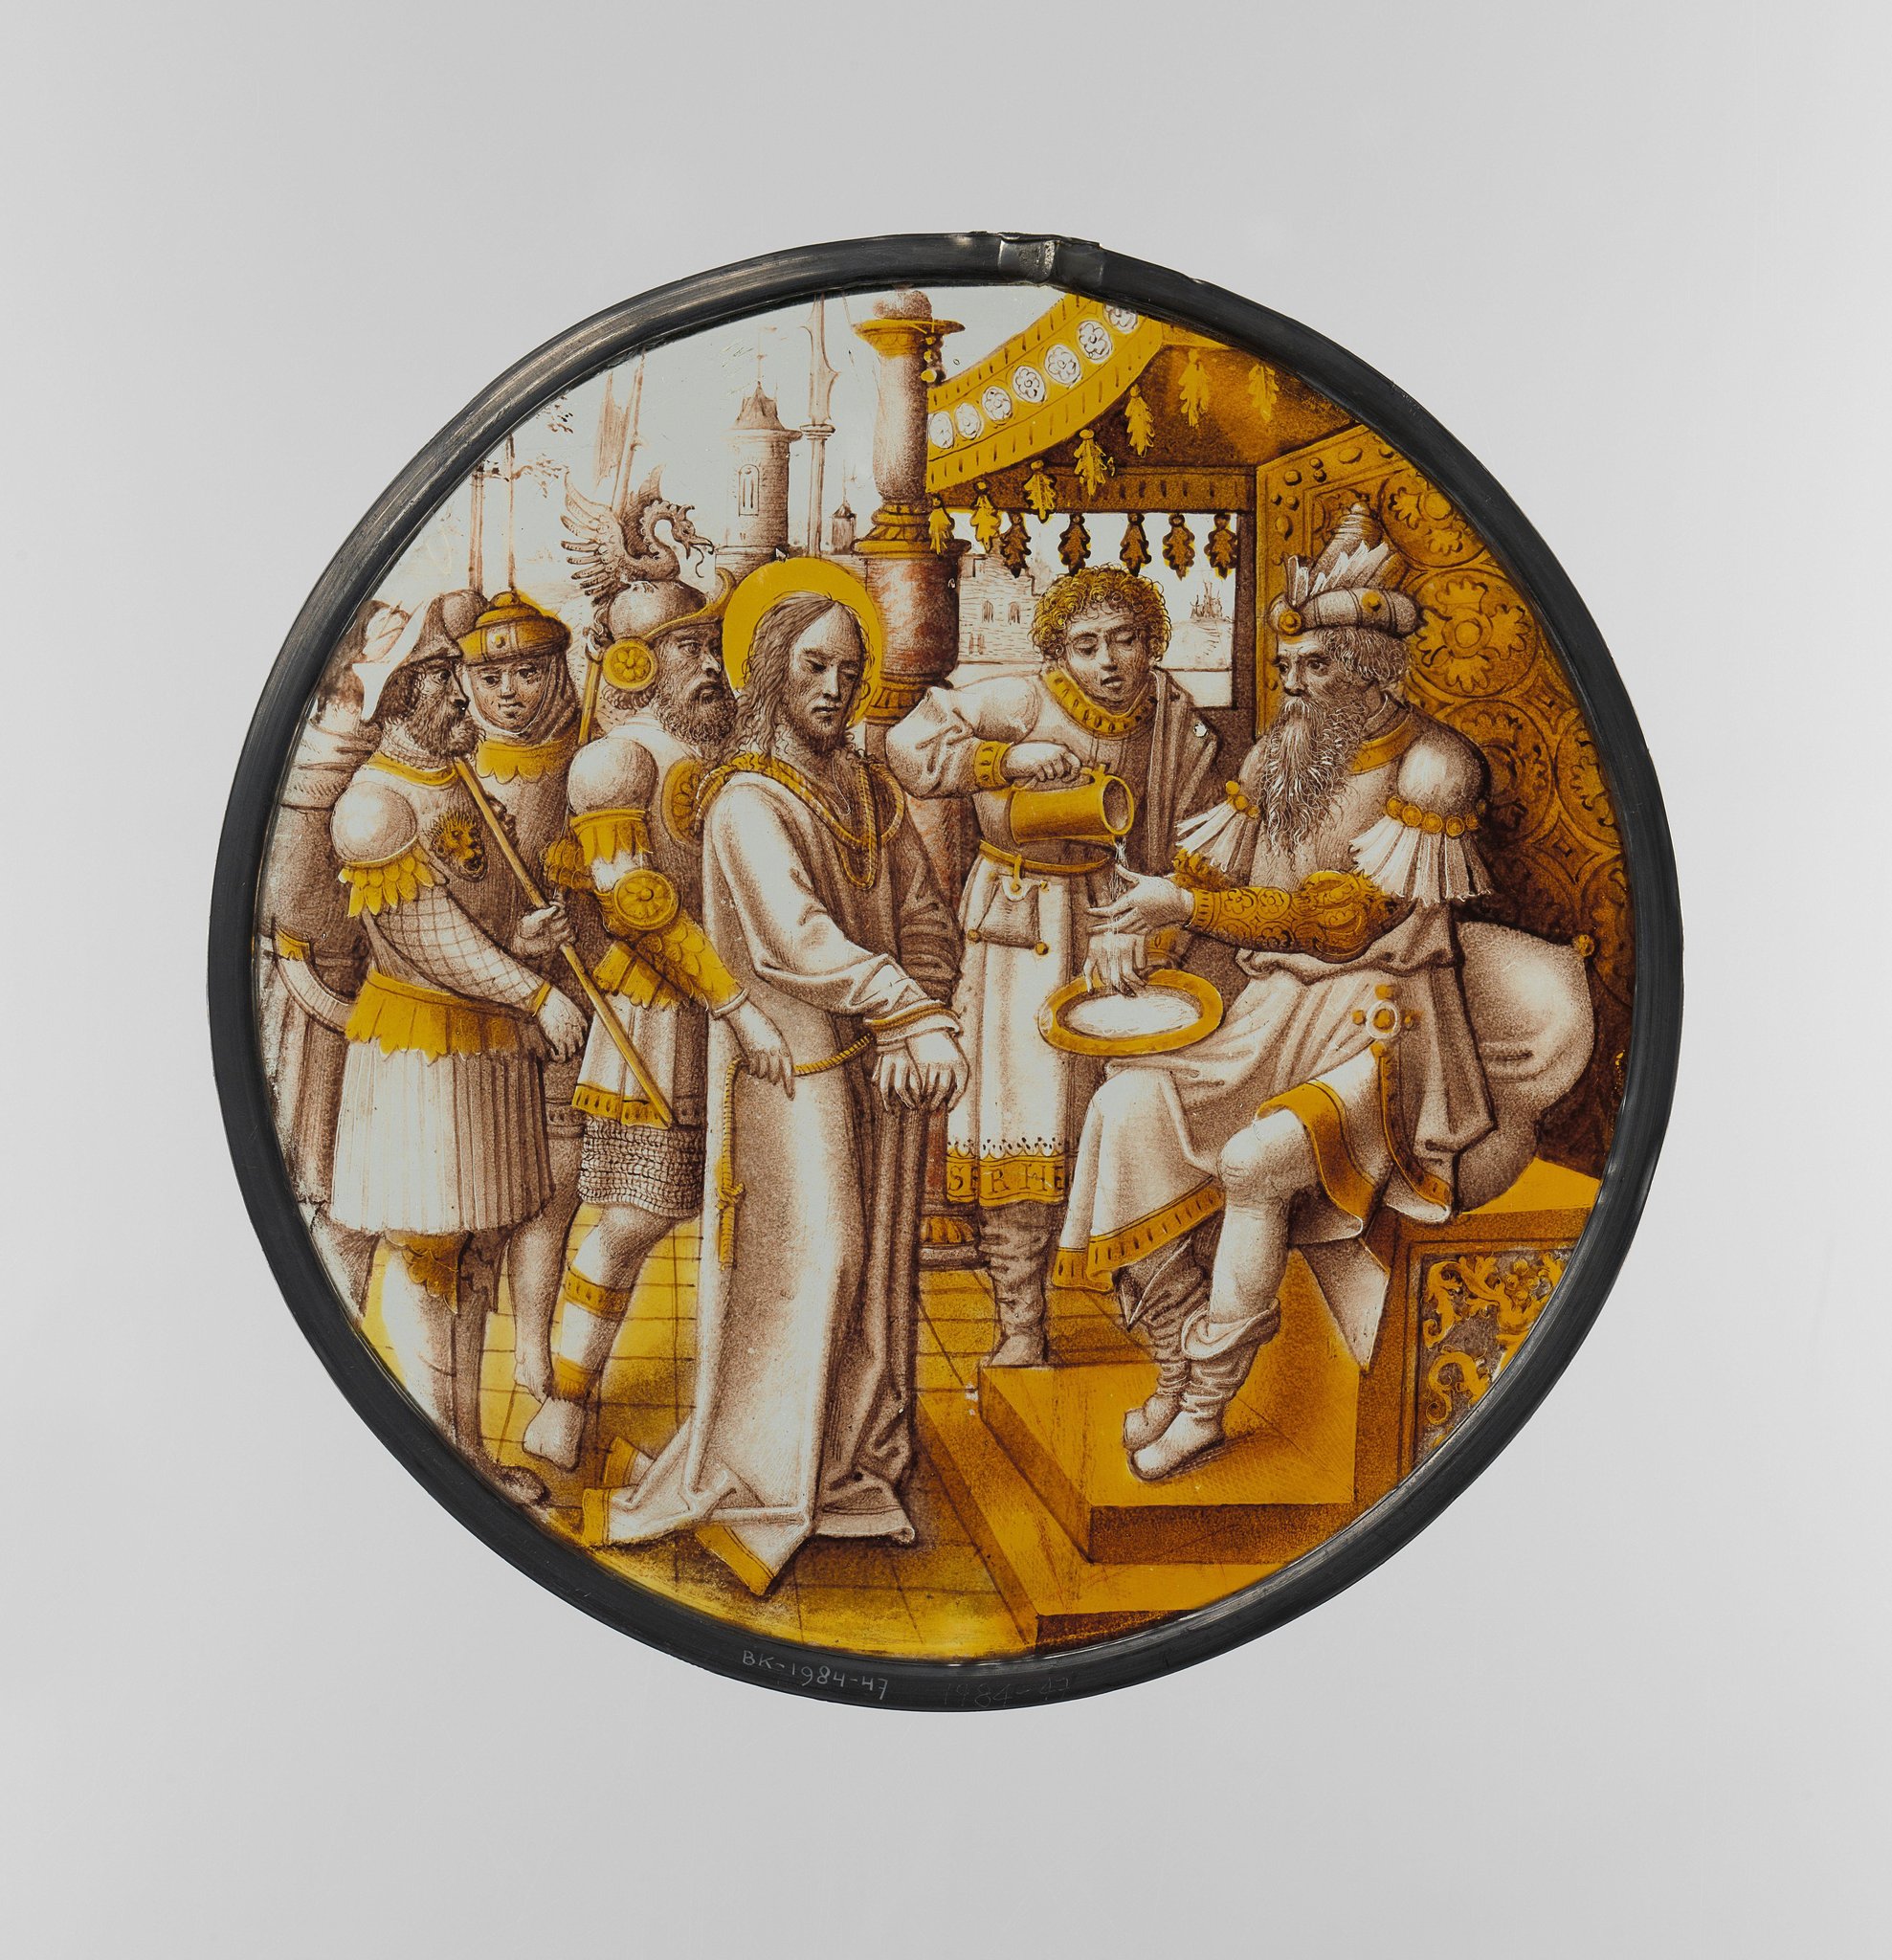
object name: light window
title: Ruit met Christus voor Pilatus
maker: aert ortkens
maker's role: draughtsman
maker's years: 1473-1540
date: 1510-1530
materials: glass, lead, pigment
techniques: leading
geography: southern netherlands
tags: pilate washing his hands (in innocence)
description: Christ Before Pilate. Stained glass. Netherlands, c. 1515. Acquired by the Rijksmuseum Foundation.